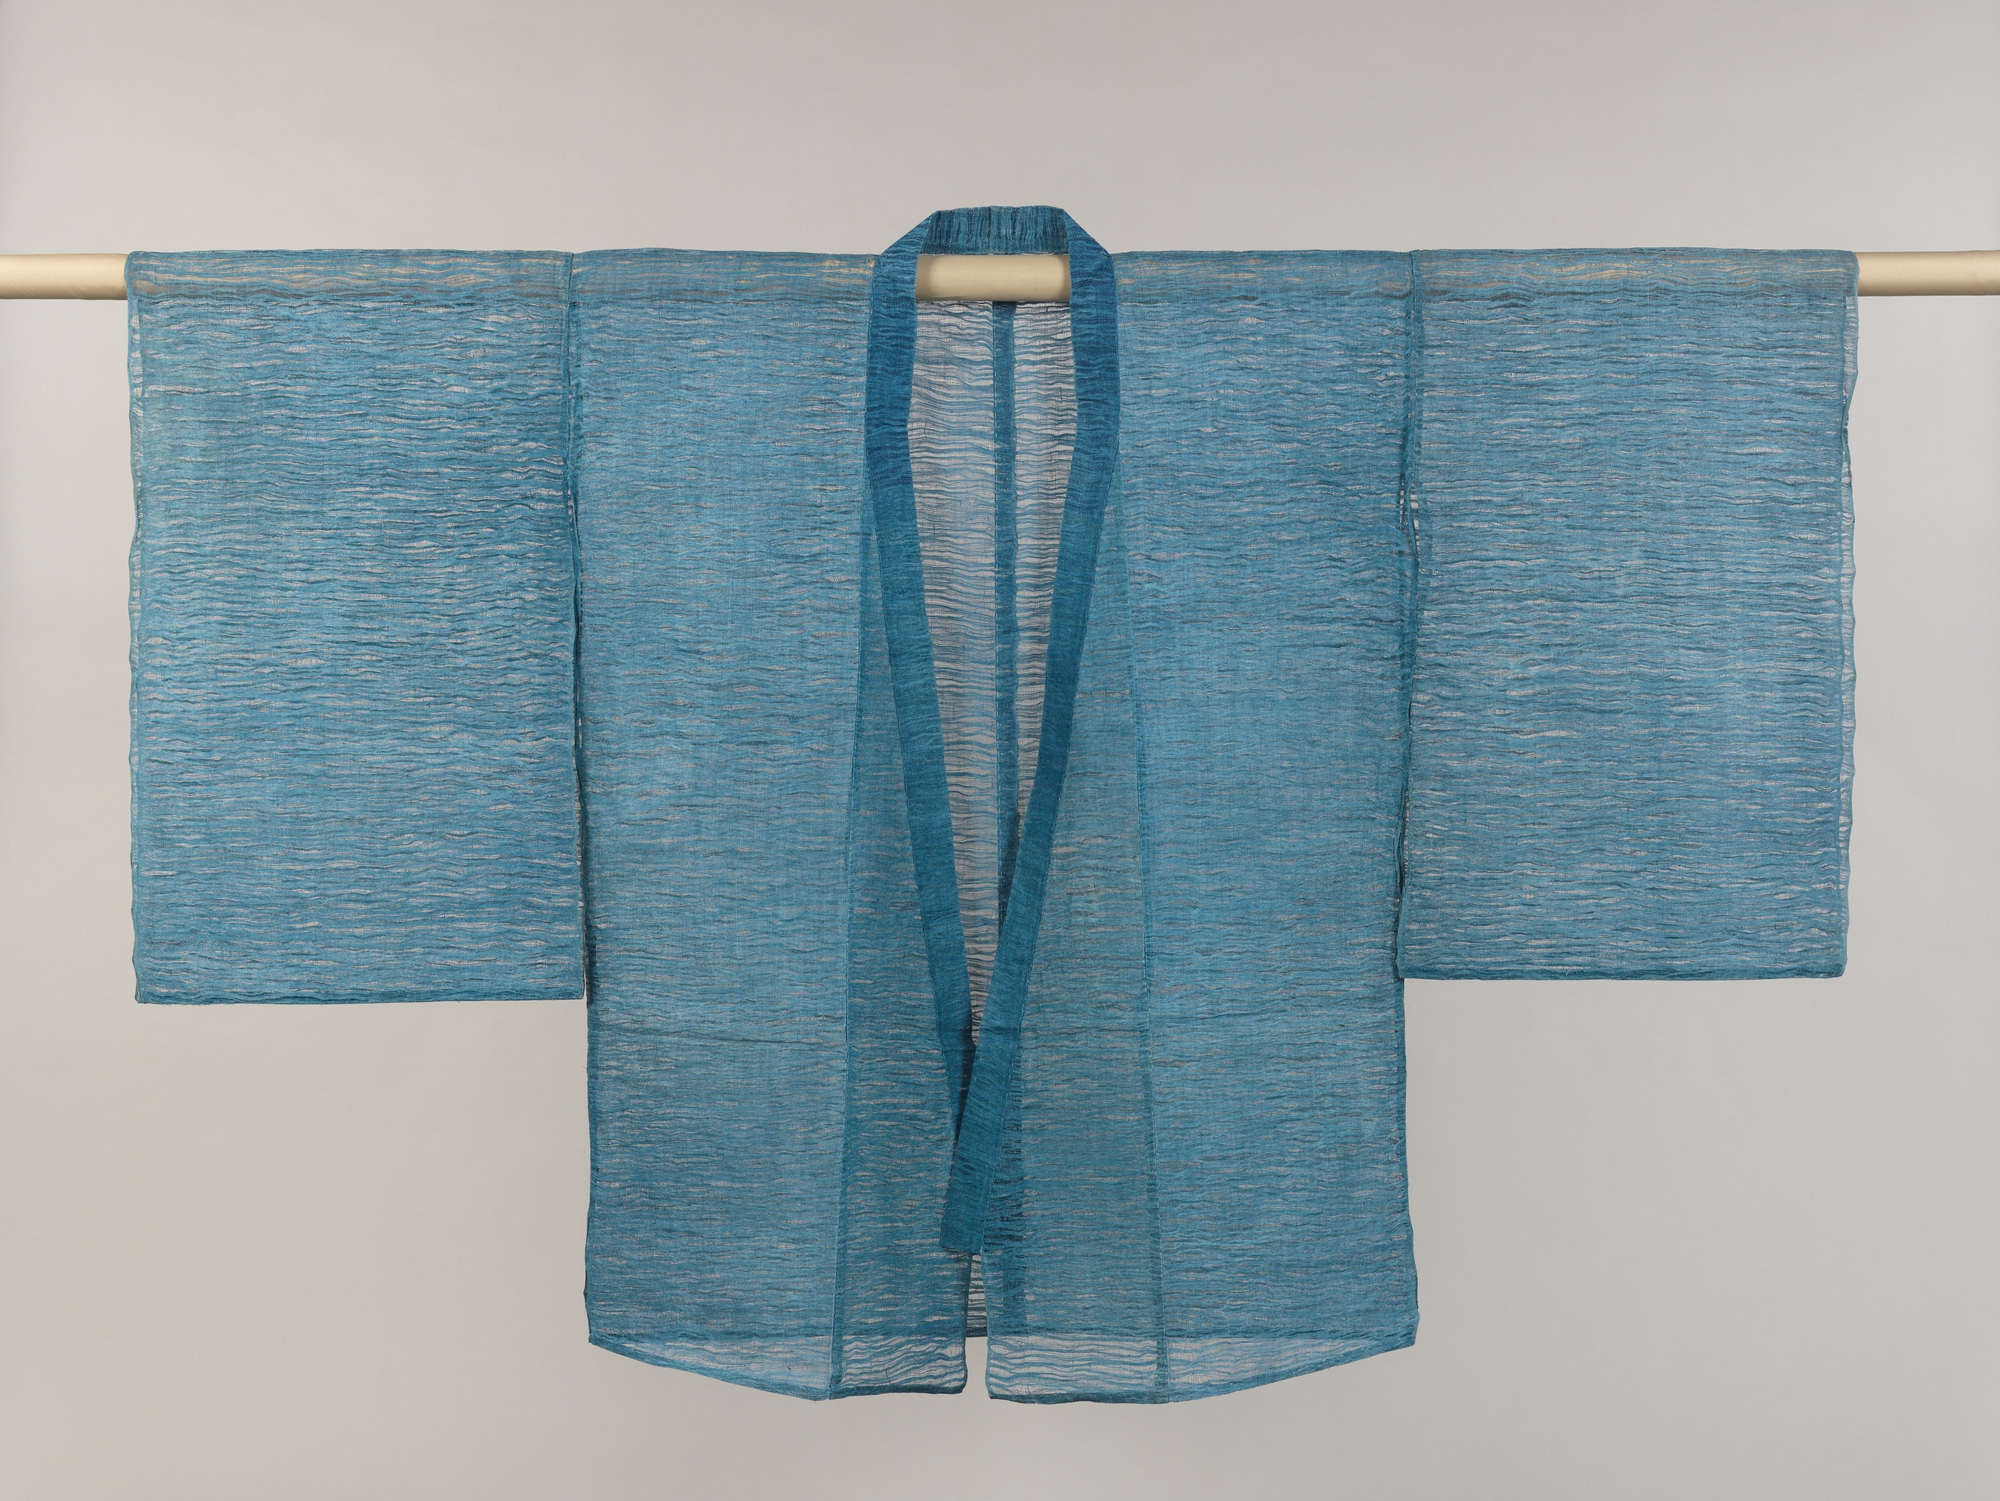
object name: noh costume mizugoromo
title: Noh Costume (Mizugoromo)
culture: japanese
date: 1801-1900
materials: fiber, hemp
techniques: weave